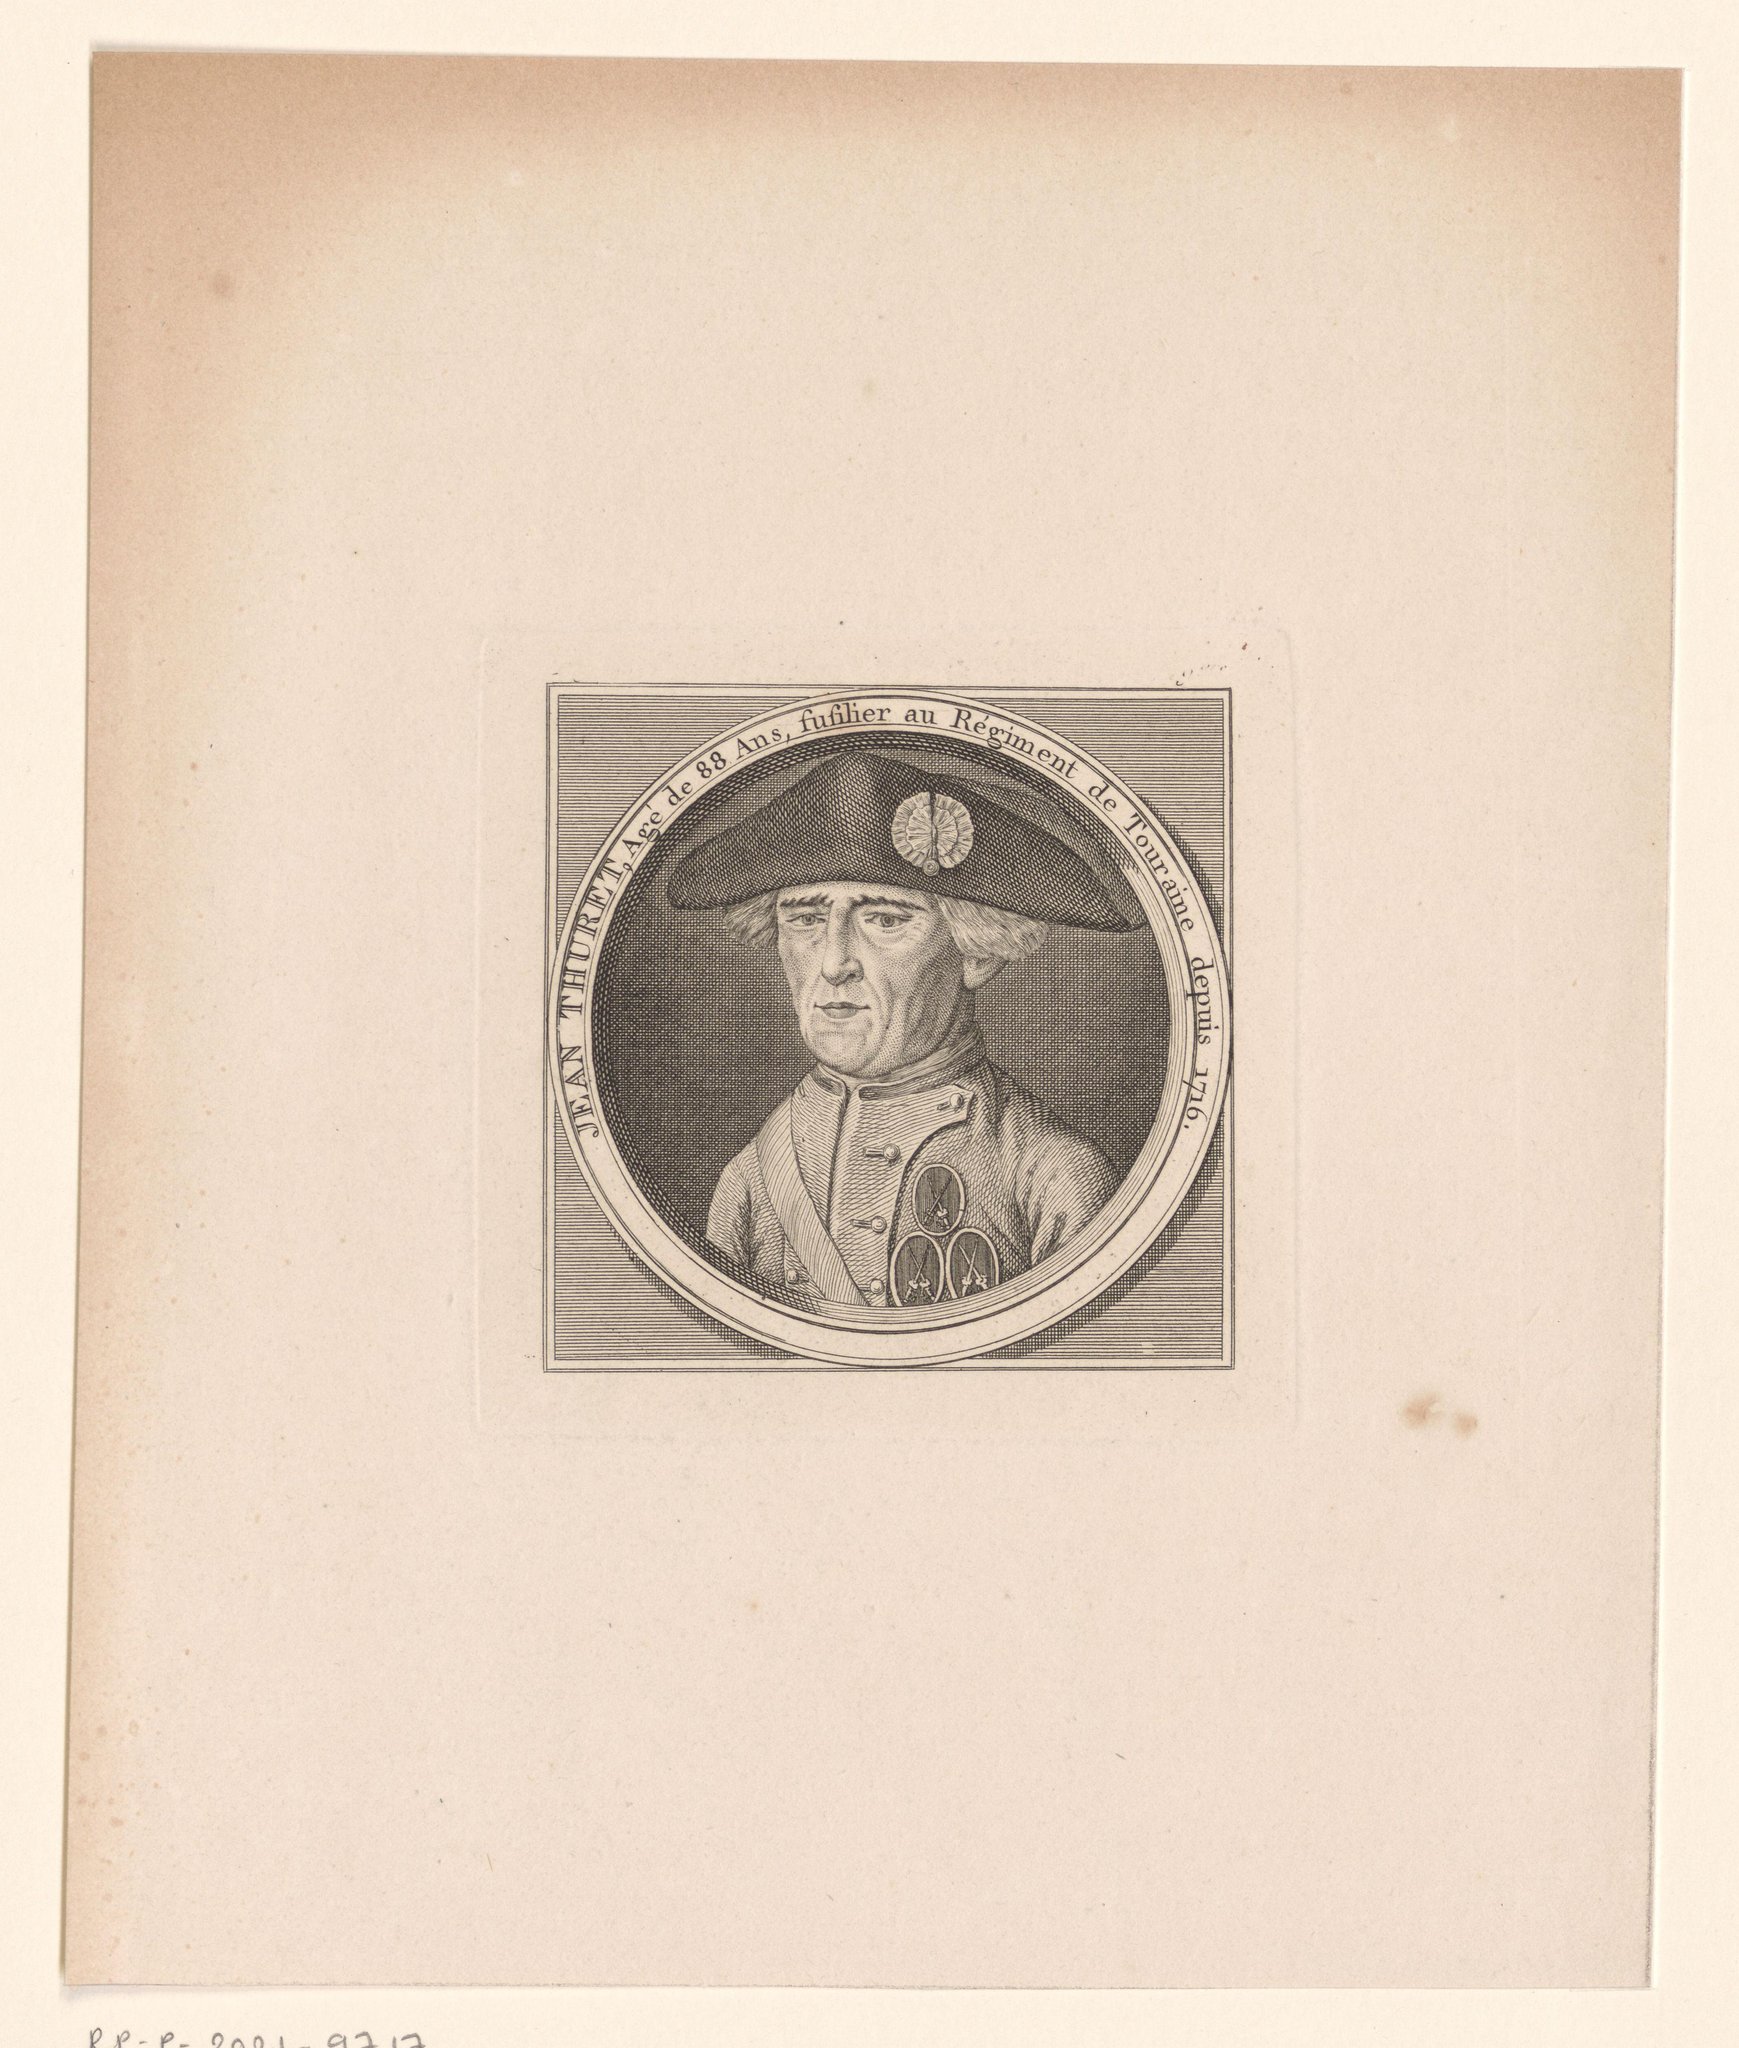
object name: print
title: Portret van Jean Thurel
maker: Anonymous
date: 1800-1824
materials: paper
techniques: etching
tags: historical persons, officer